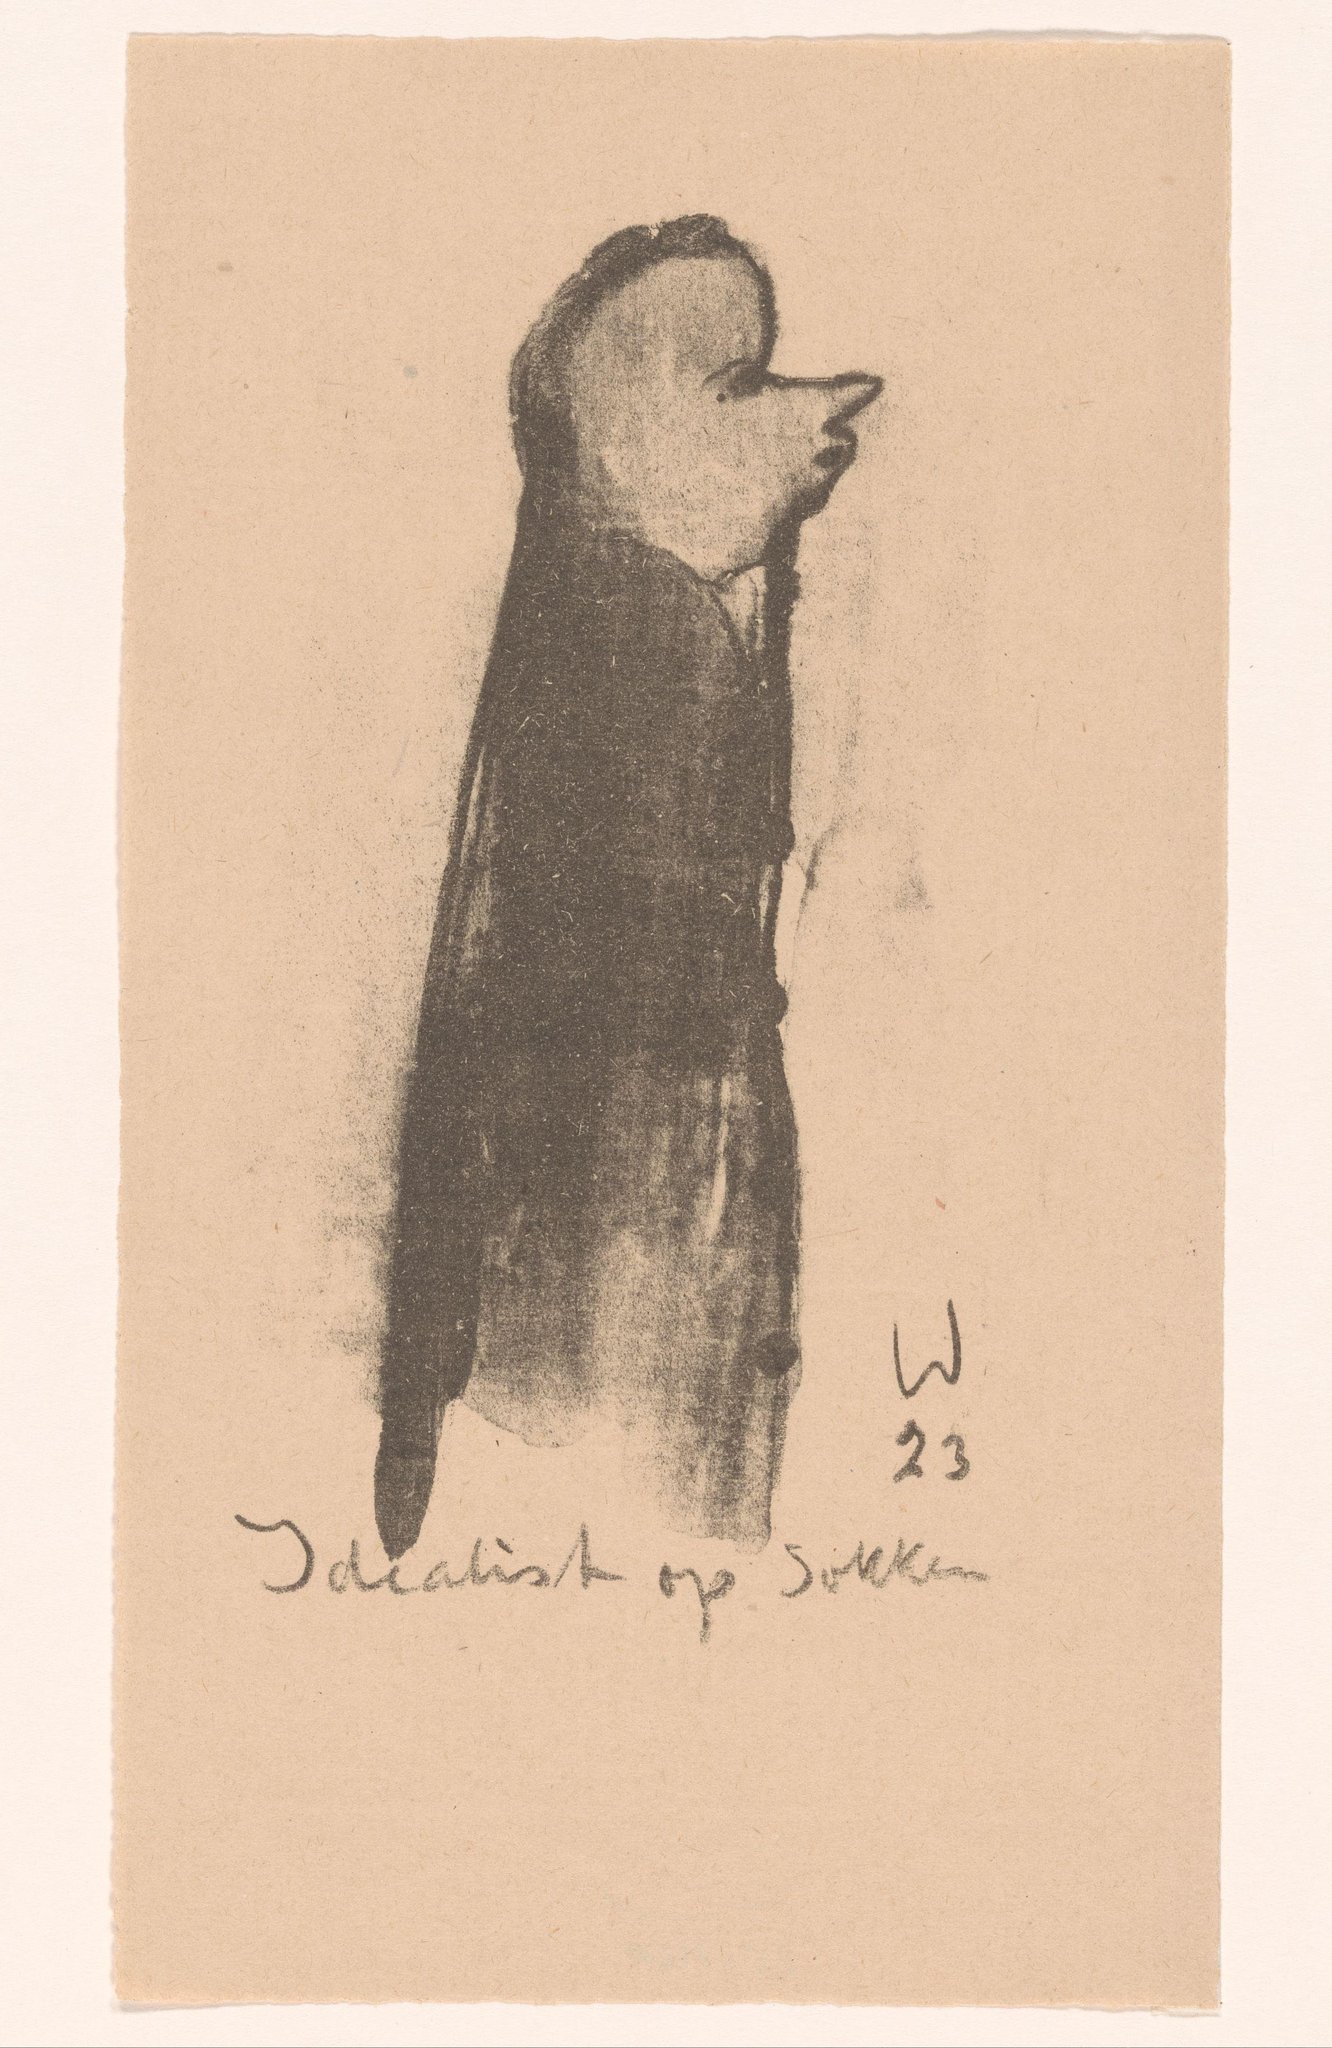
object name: print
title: Idealisten II en verdere Kanttekeningen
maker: erich wichmann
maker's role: print maker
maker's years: 1890-1929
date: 1923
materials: paper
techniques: lithograph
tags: caricatures (human types)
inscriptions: collector's mark: Lugt 2228